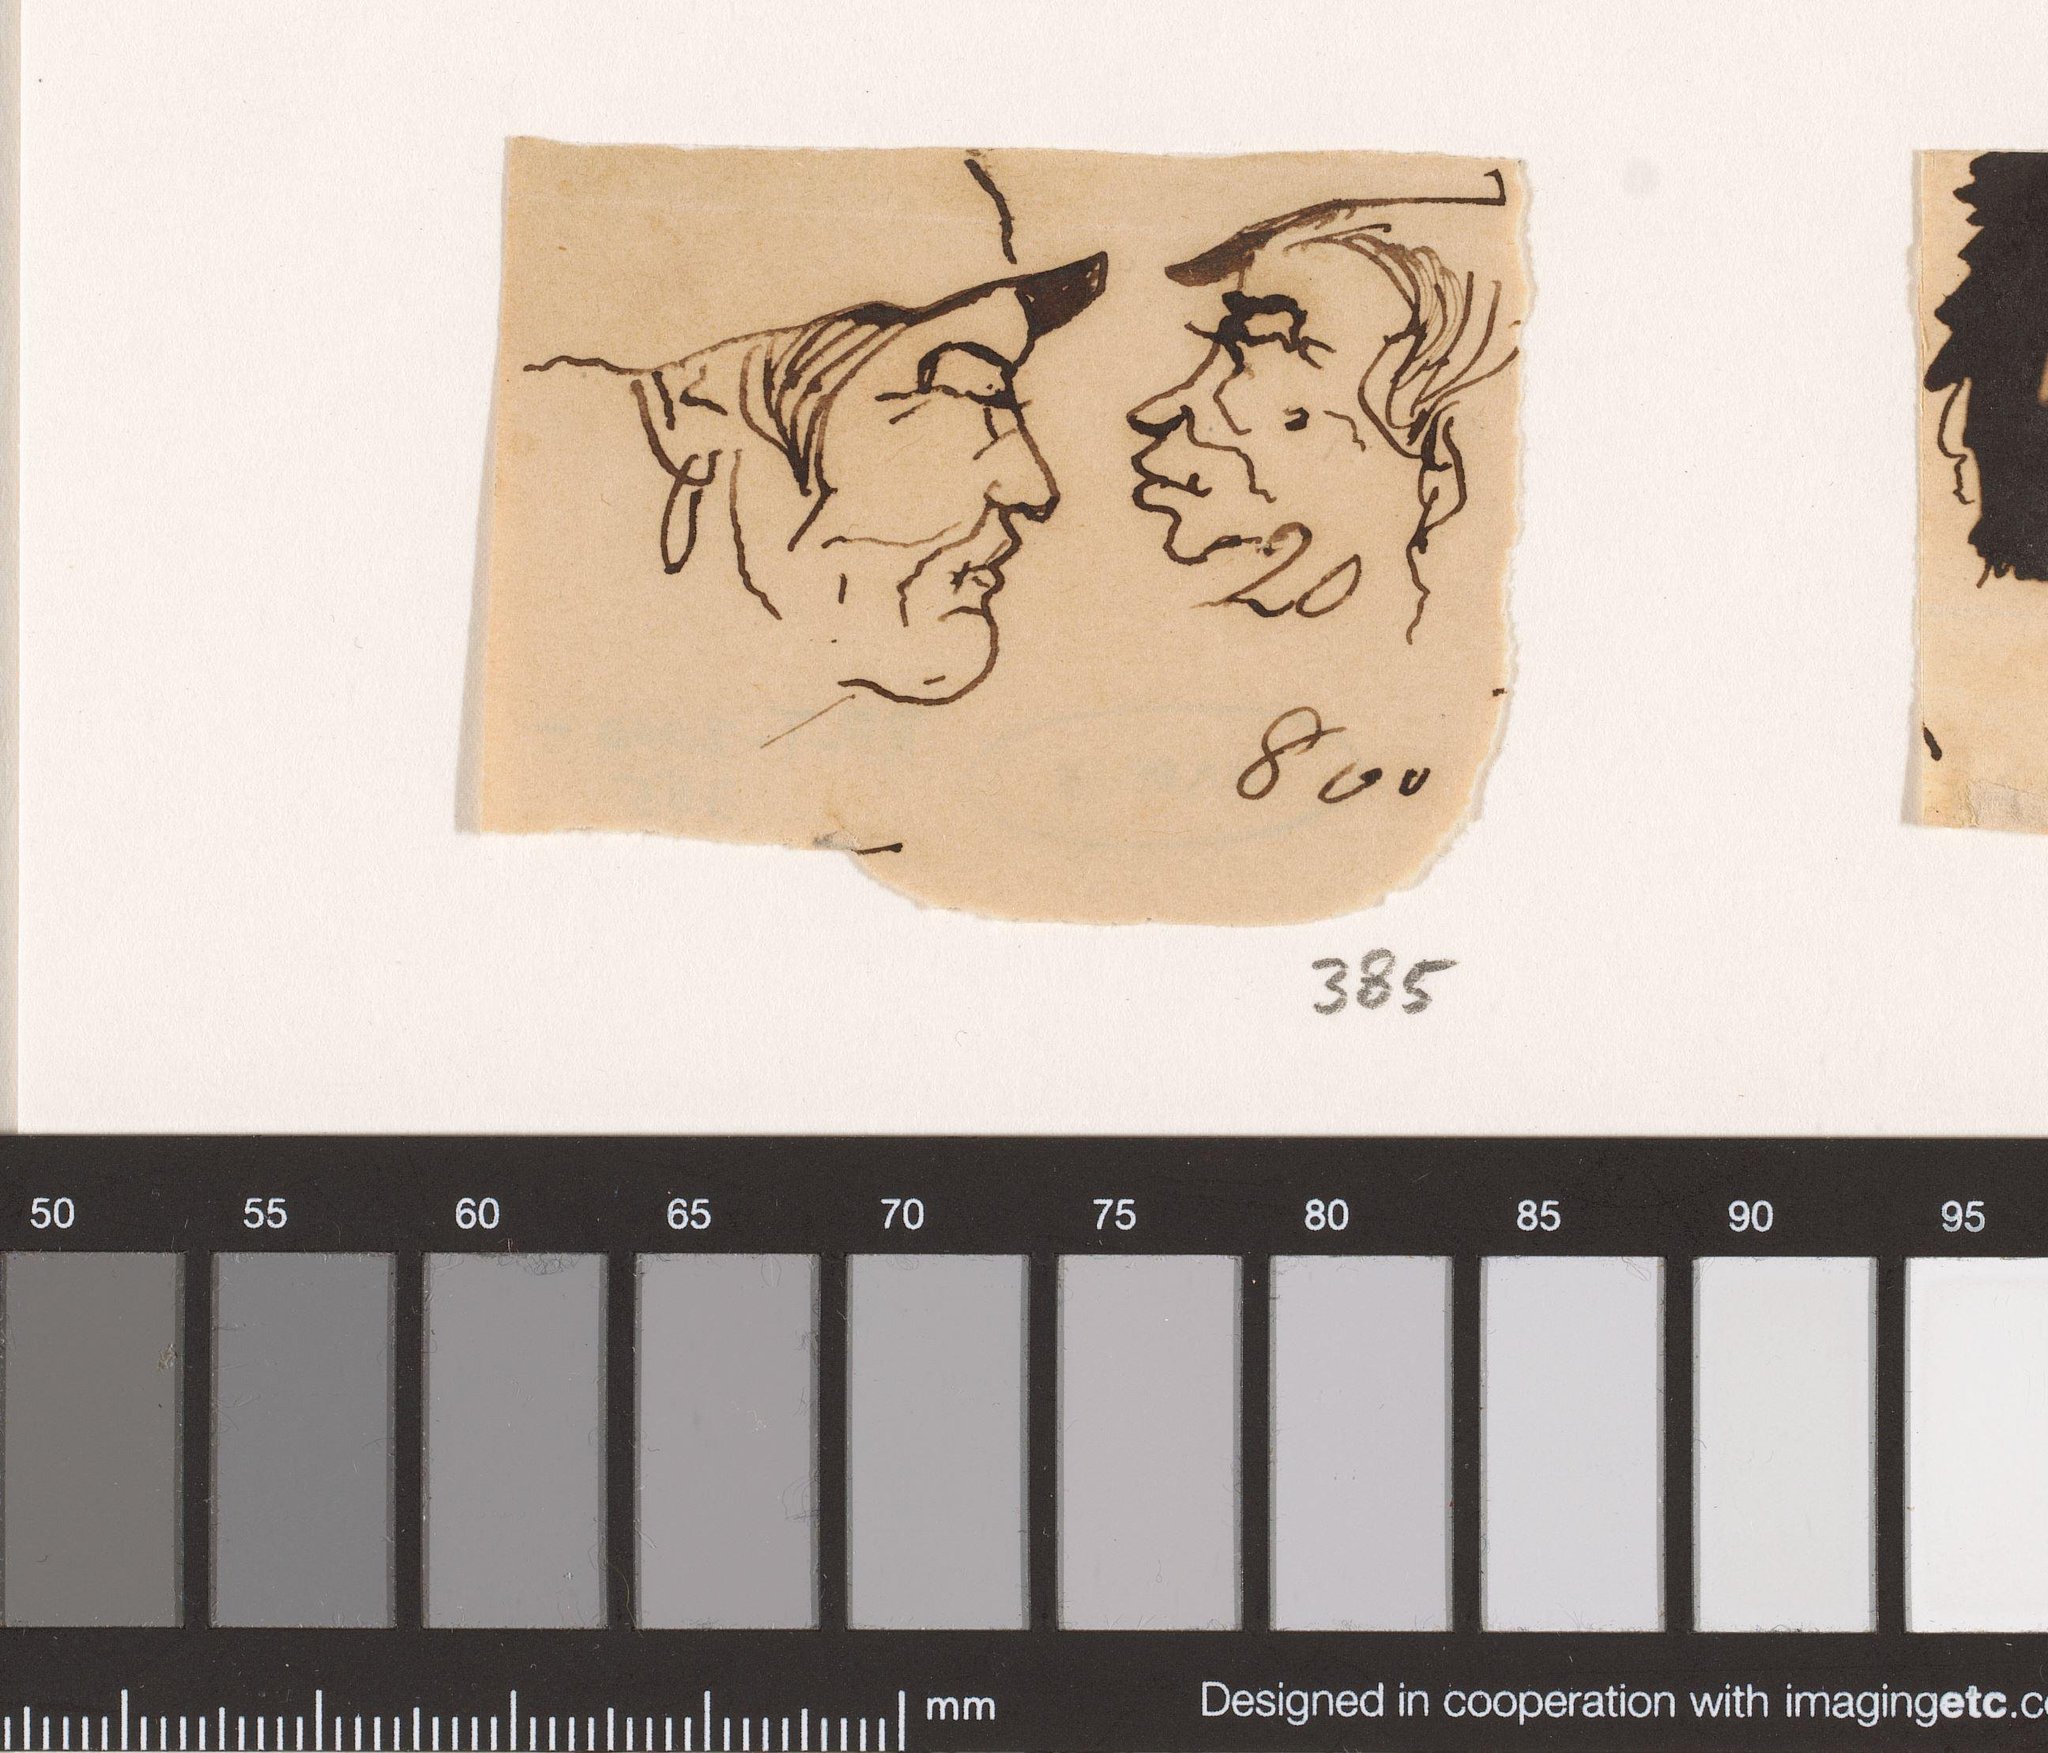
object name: drawing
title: Twee koppen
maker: johannes tavenraat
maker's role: draughtsman, painter, print maker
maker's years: 1809-1881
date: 1840-1880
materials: ink, paper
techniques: pen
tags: caricatures (human types)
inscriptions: collector's mark: Lugt 2228